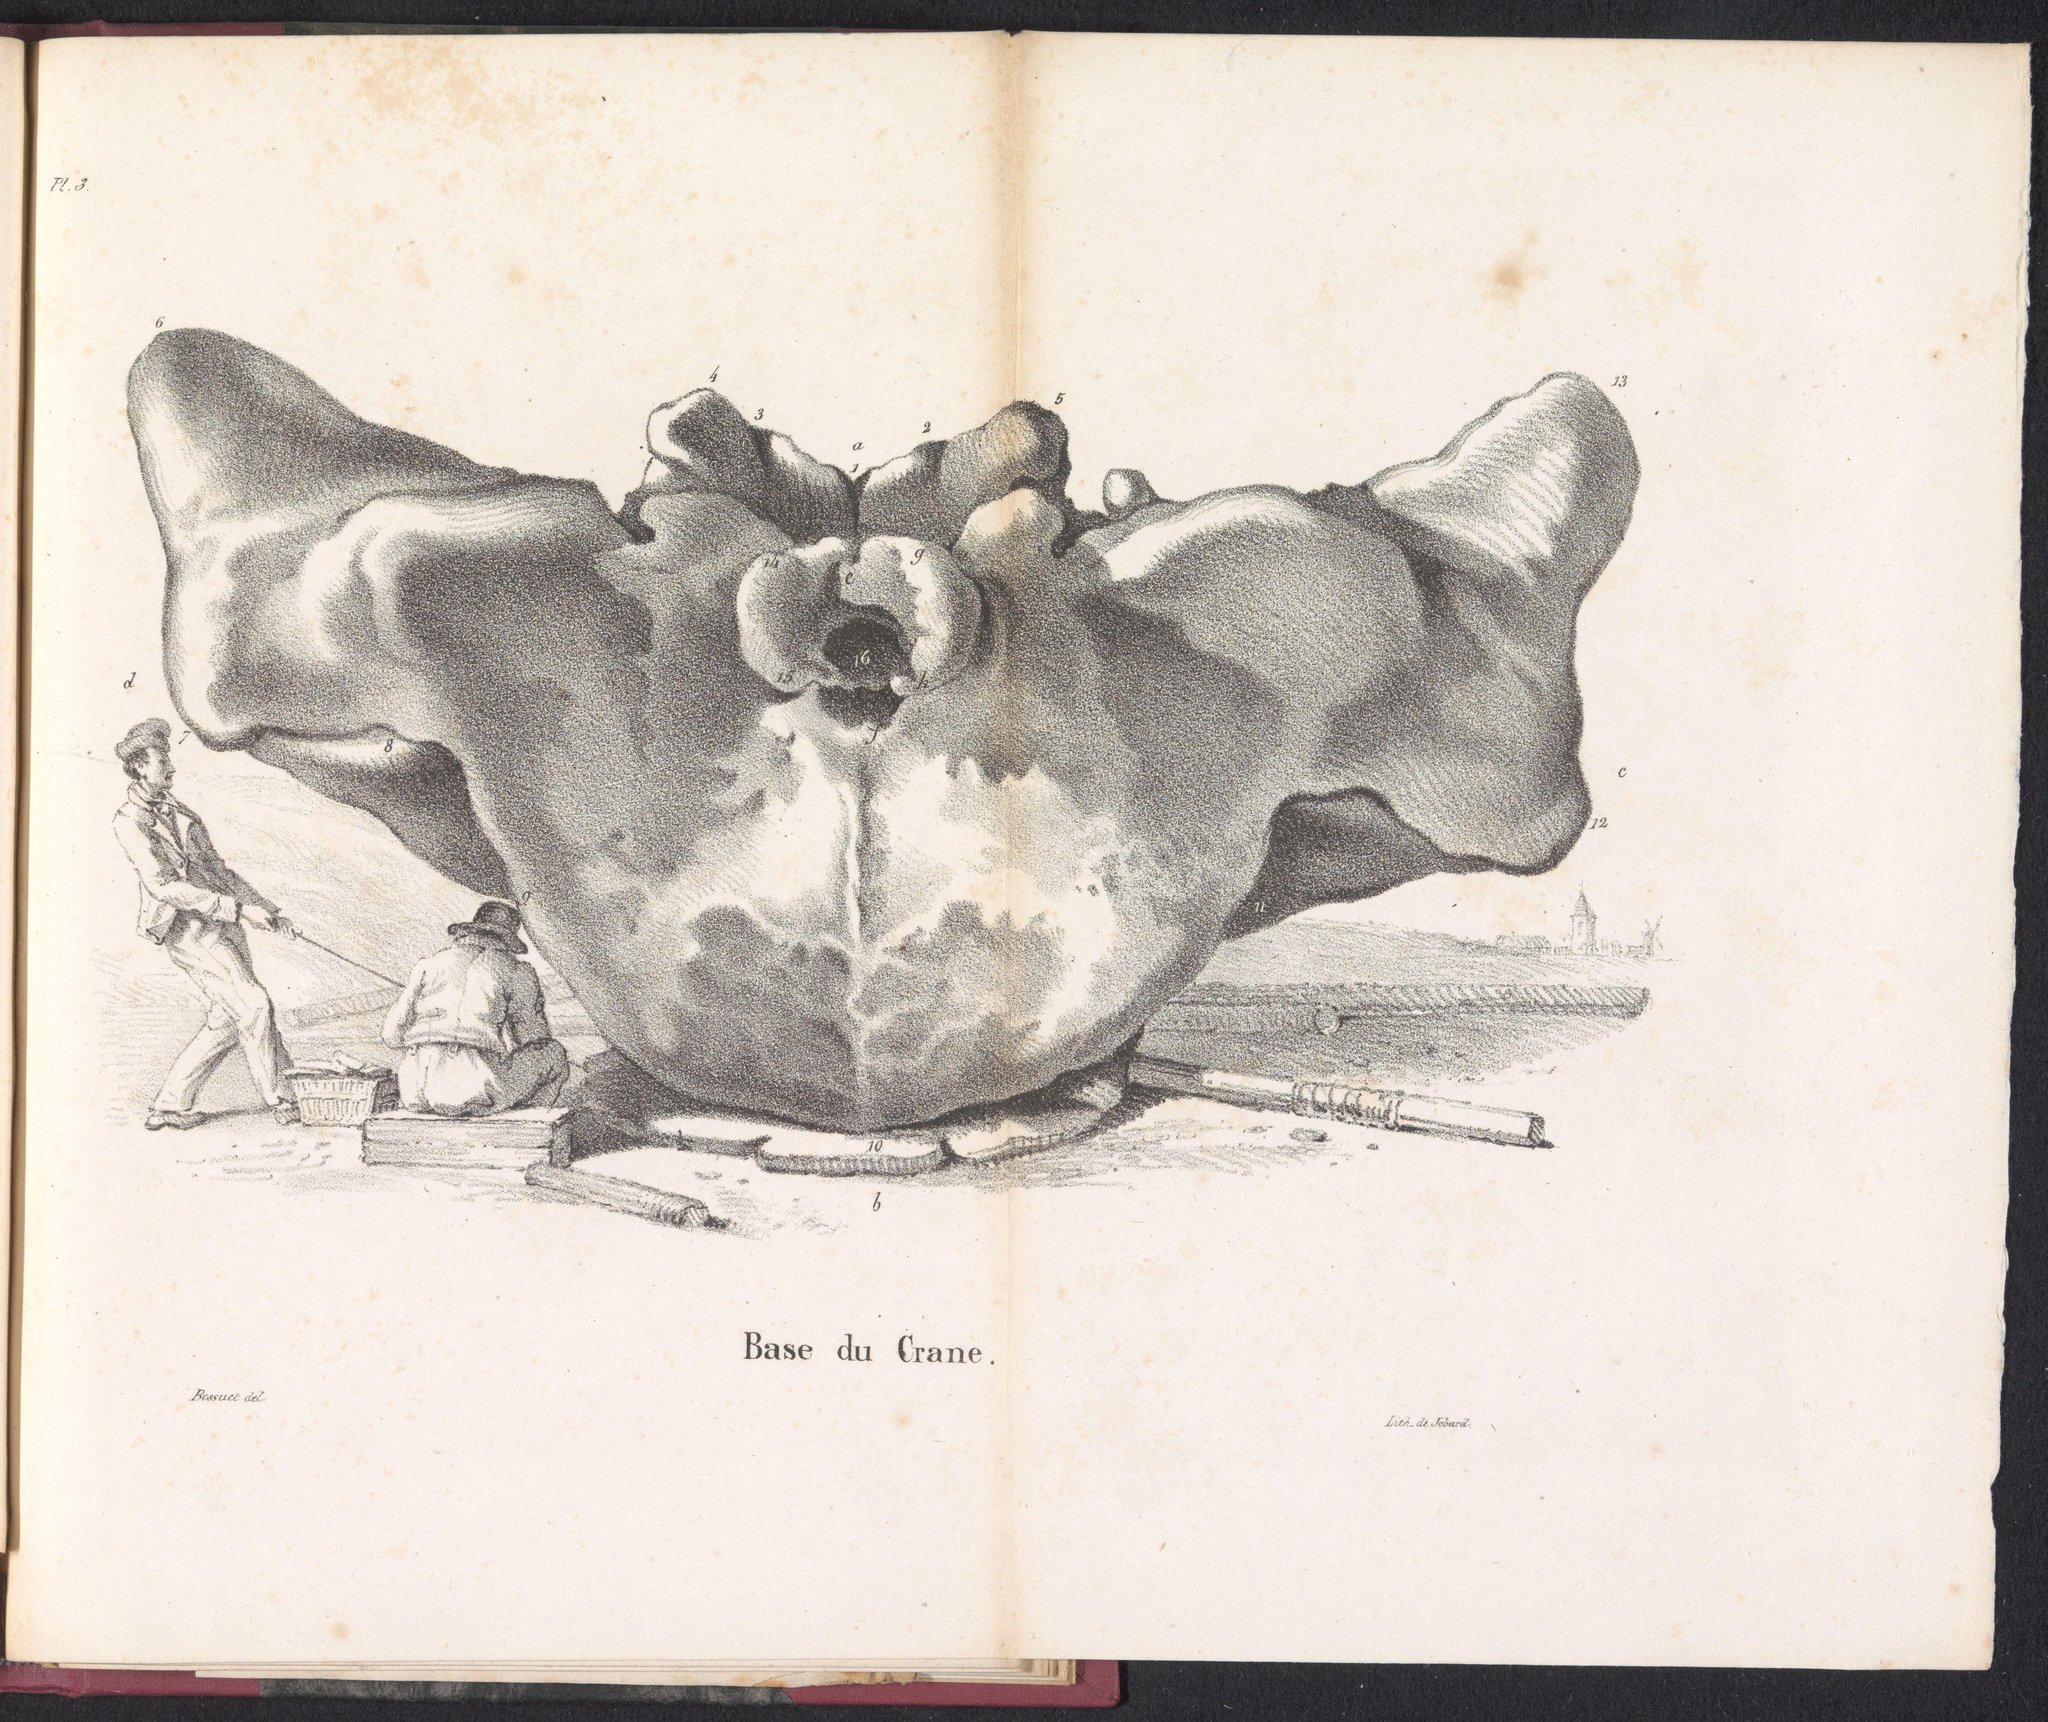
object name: print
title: Base du Crane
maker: jean baptiste ambroise marcellin jobard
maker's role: print maker, publisher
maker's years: 1792-1861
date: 1828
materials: paper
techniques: lithograph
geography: brussels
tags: herman kessels, swimming mammals: whale (+ dying animal; death of animal; dead animal)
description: Achterzijde van de schedel en kaken van de walvis. Links twee mannen. Illustratie in een publicatie over de walvis gestrand op 4 november 1827 bij Oostende. De walvis was eigendom van H. Kessels en J. Dubar.